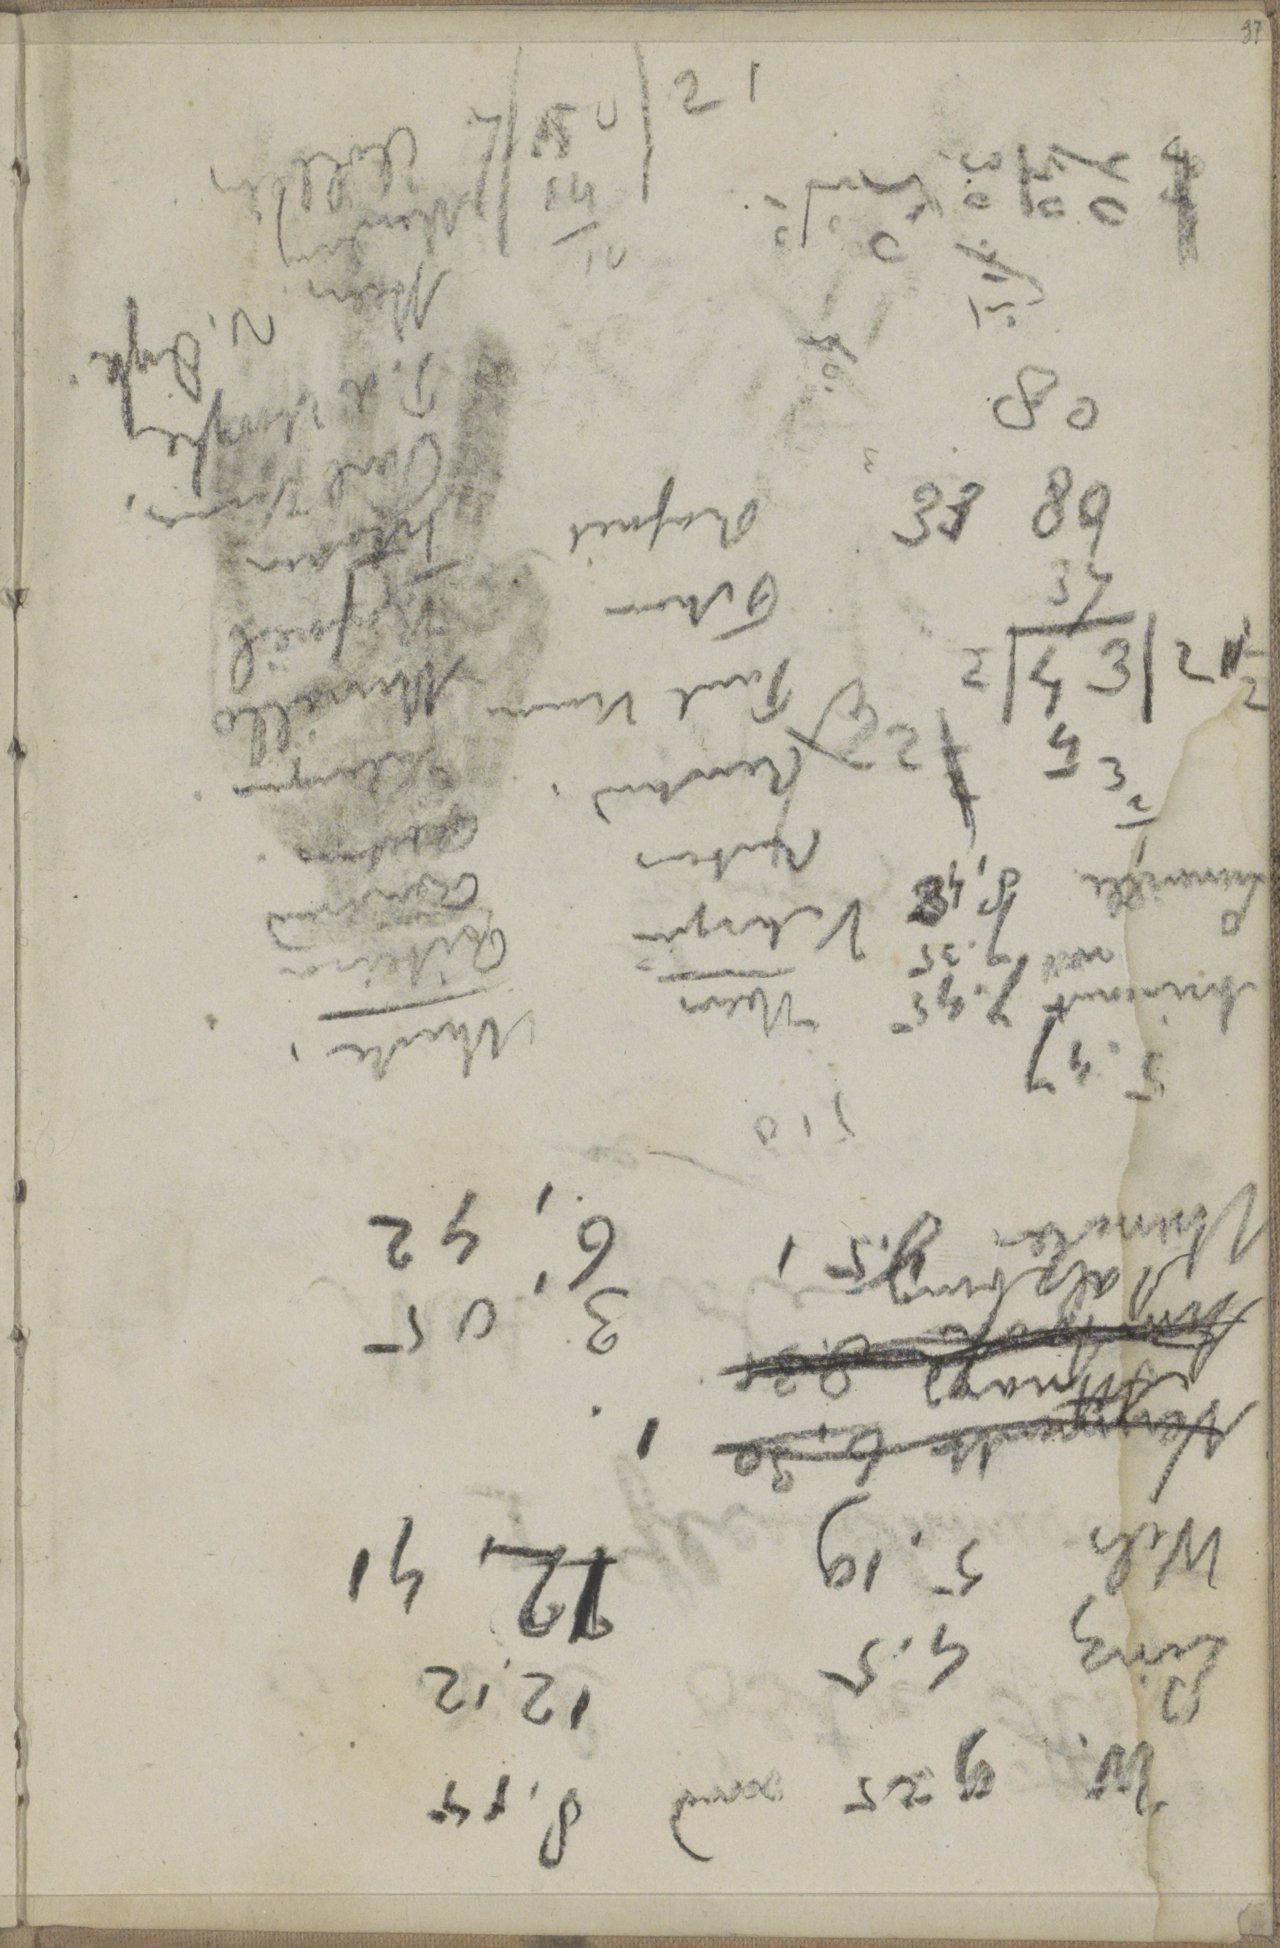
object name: sketchbook leaf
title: Blad met reisnotities en berekeningen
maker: marius bauer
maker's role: draughtsman, print maker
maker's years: 1867-1932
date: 1888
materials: chalk, paper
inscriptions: annotation: ‘W. 9.25 [...] 8.15/ Linz 4.5 12.12/ Wels 5.19 12.41 [...]’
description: Pagina 97 uit een schetsboek met 49 bladen.